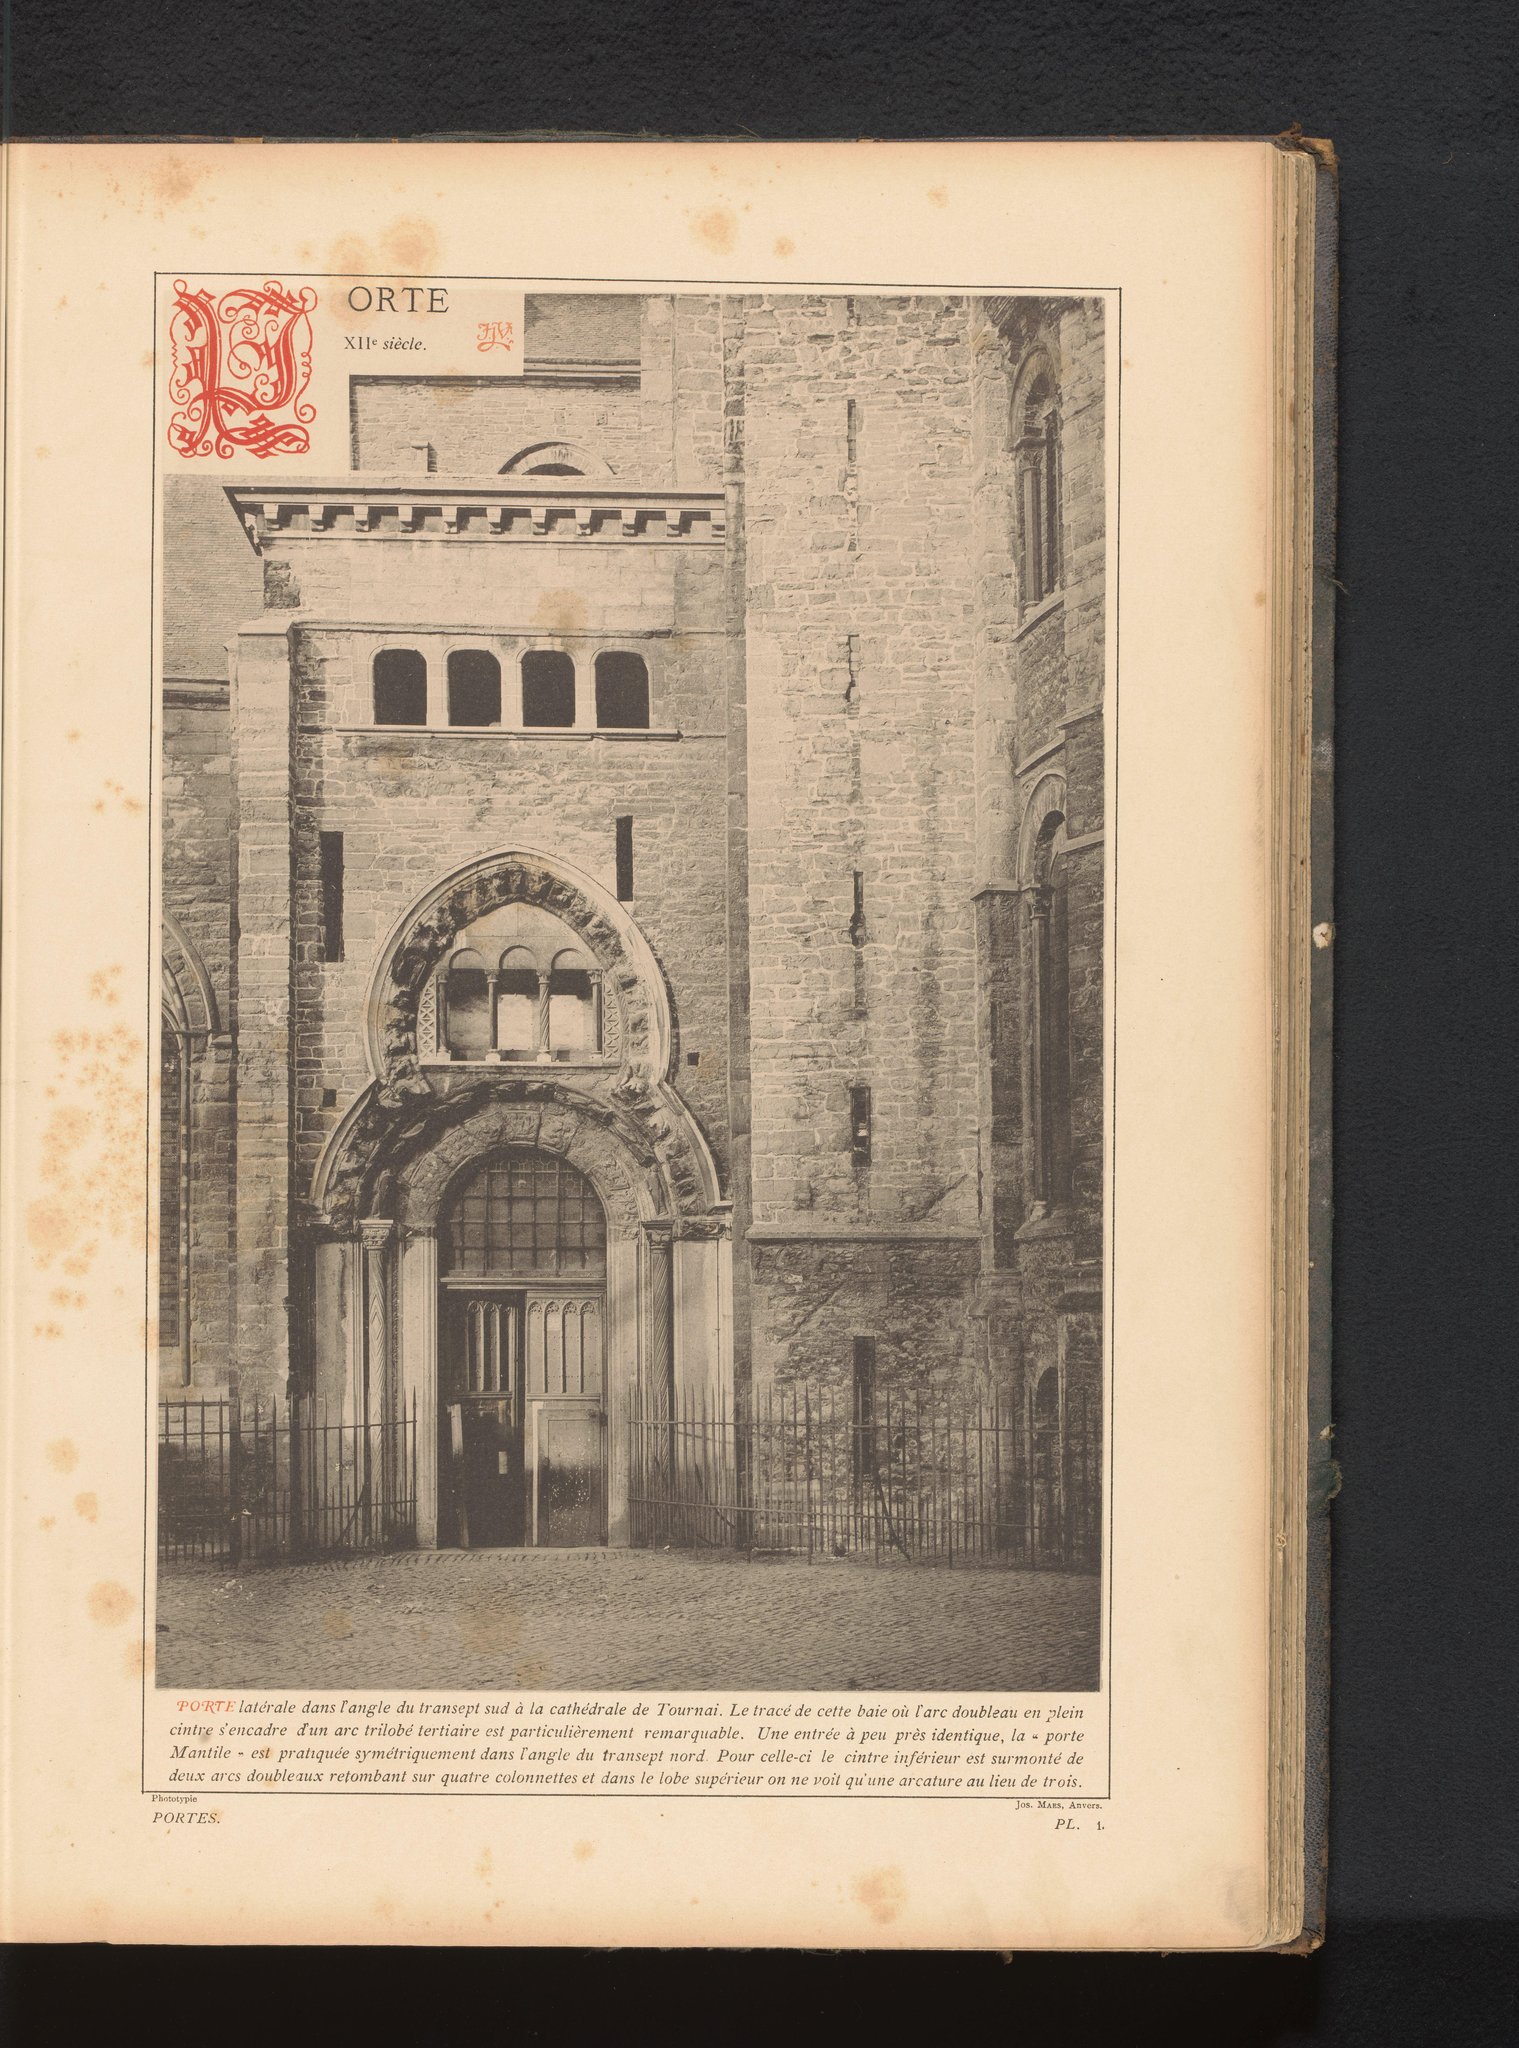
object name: photomechanical print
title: Ingang van het zuidelijk transept van de Onze-Lieve-Vrouwekathedraal in Doornik, België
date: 1882-1887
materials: paper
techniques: photograph, photolithography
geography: antwerp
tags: gate, entrance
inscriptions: monogram: ‘JJvY’, inscription: ‘PORTE latérale dans (...)’, inscription: ‘PORTES. - PL. 1.’